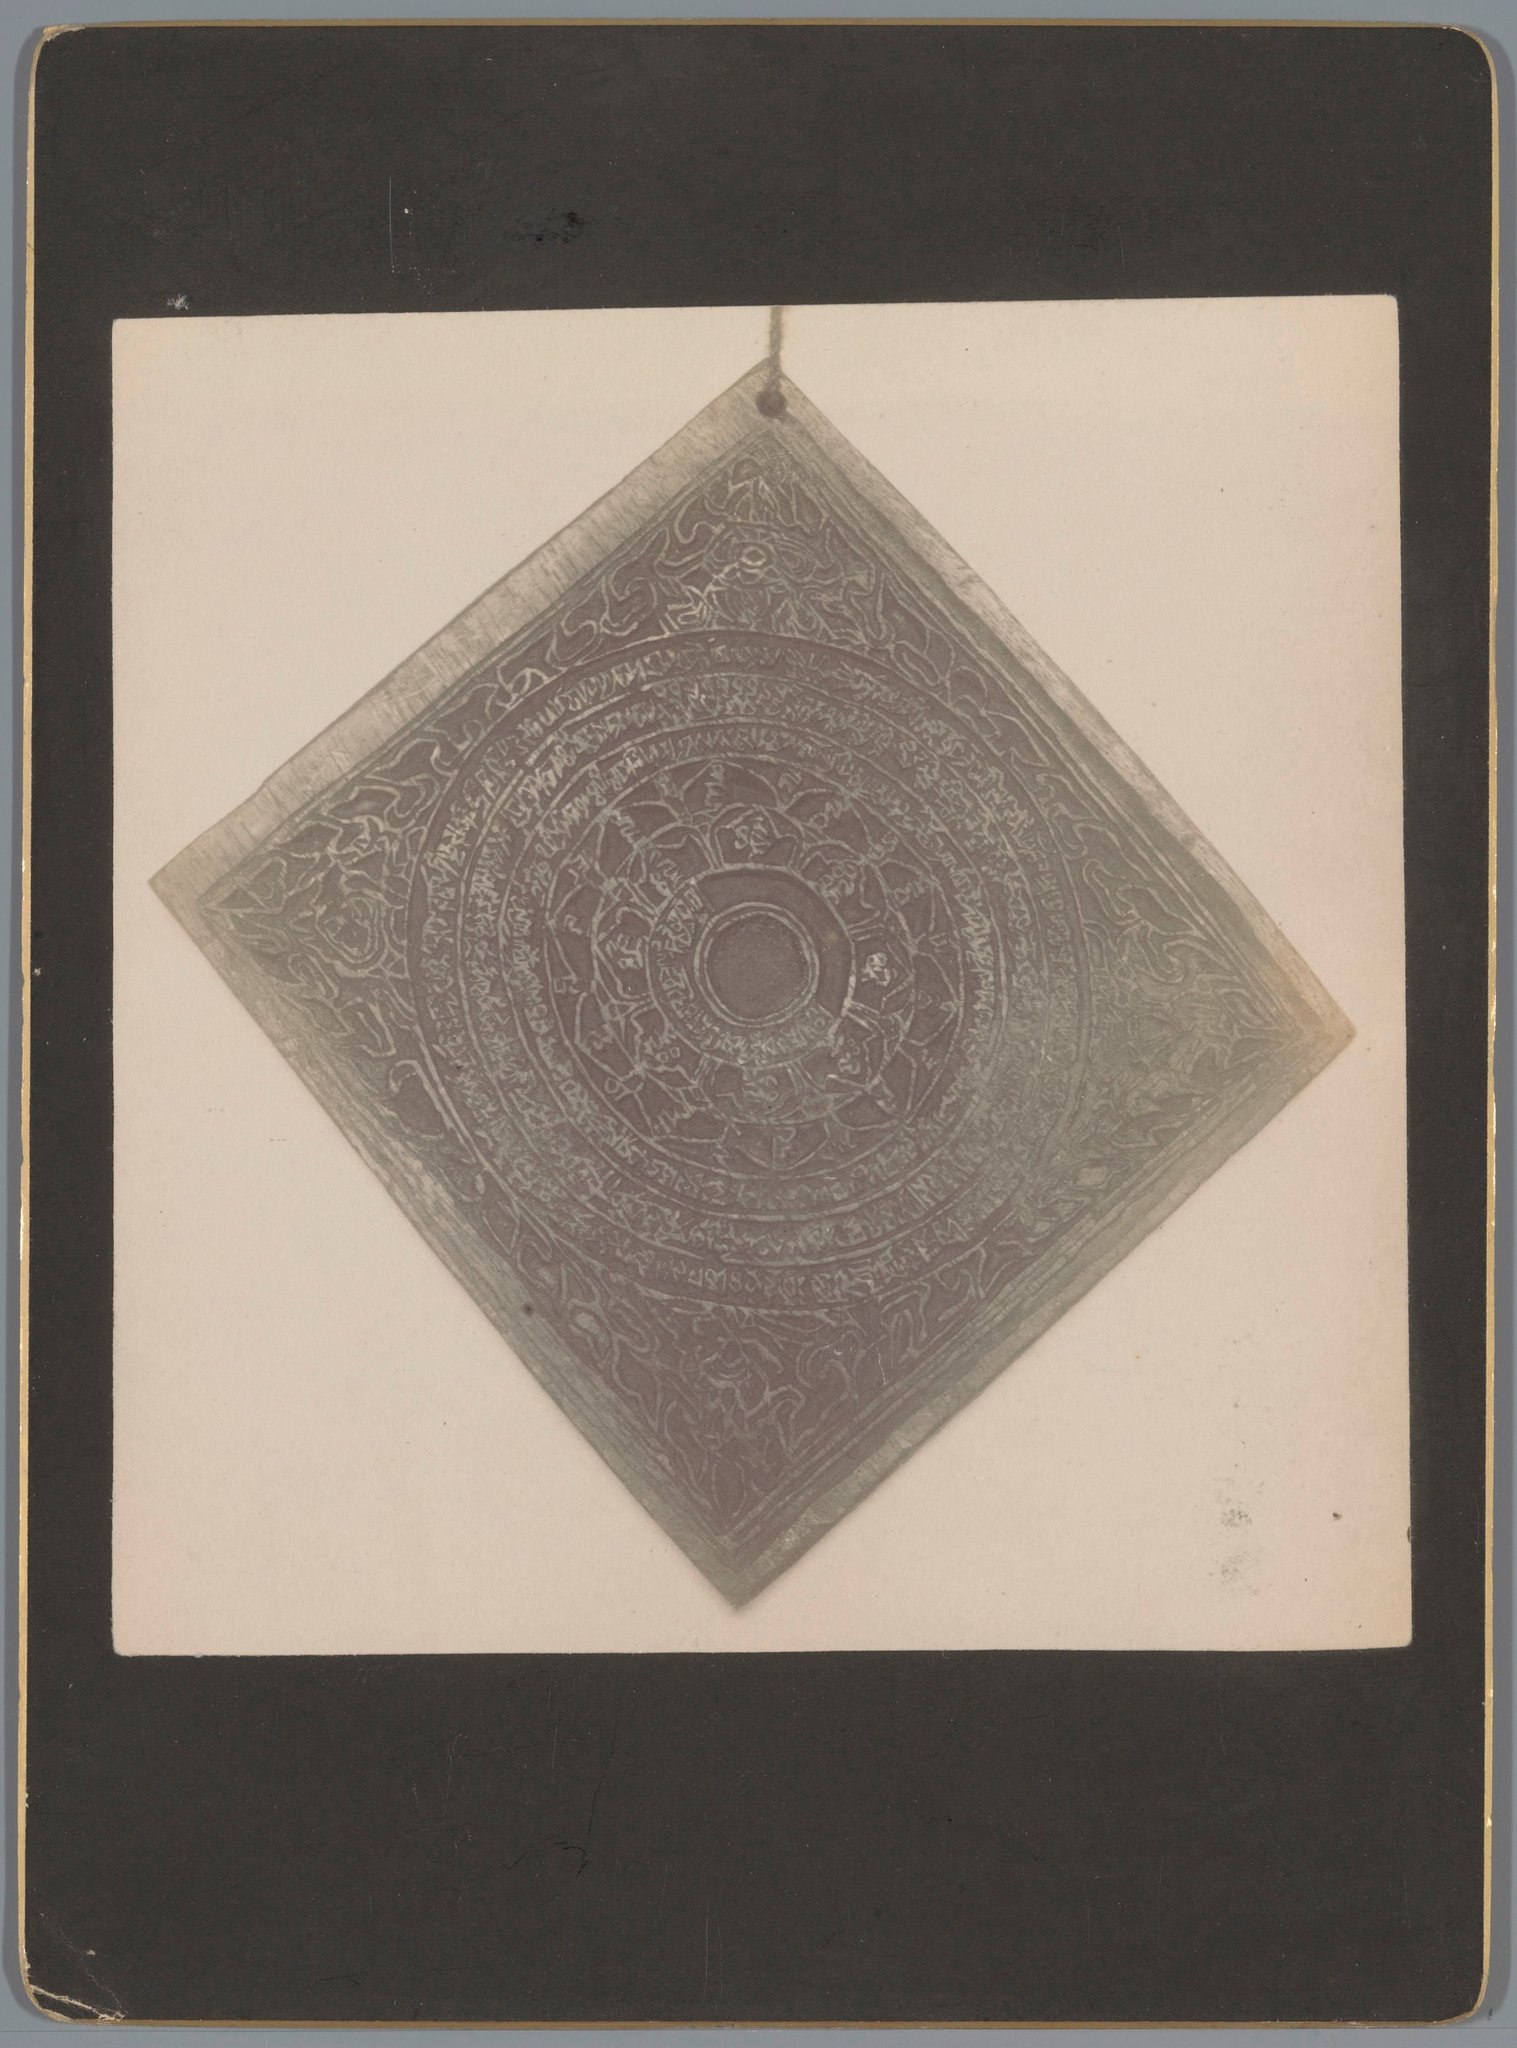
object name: photograph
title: Rijks Ethnographisch Museum Serie 1119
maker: Anonymous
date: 1897-1910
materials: cardboard, paper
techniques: albumen print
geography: rijks ethnographisch museum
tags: tools, implements of printer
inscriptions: inscription: ‘Rijks Ethnographisch Museum Serie 1119/ No 84/ Houten matrijs voor het drukken van het/ voornaamste amulet "De vereenigde Lotus harten"/ Thibet’